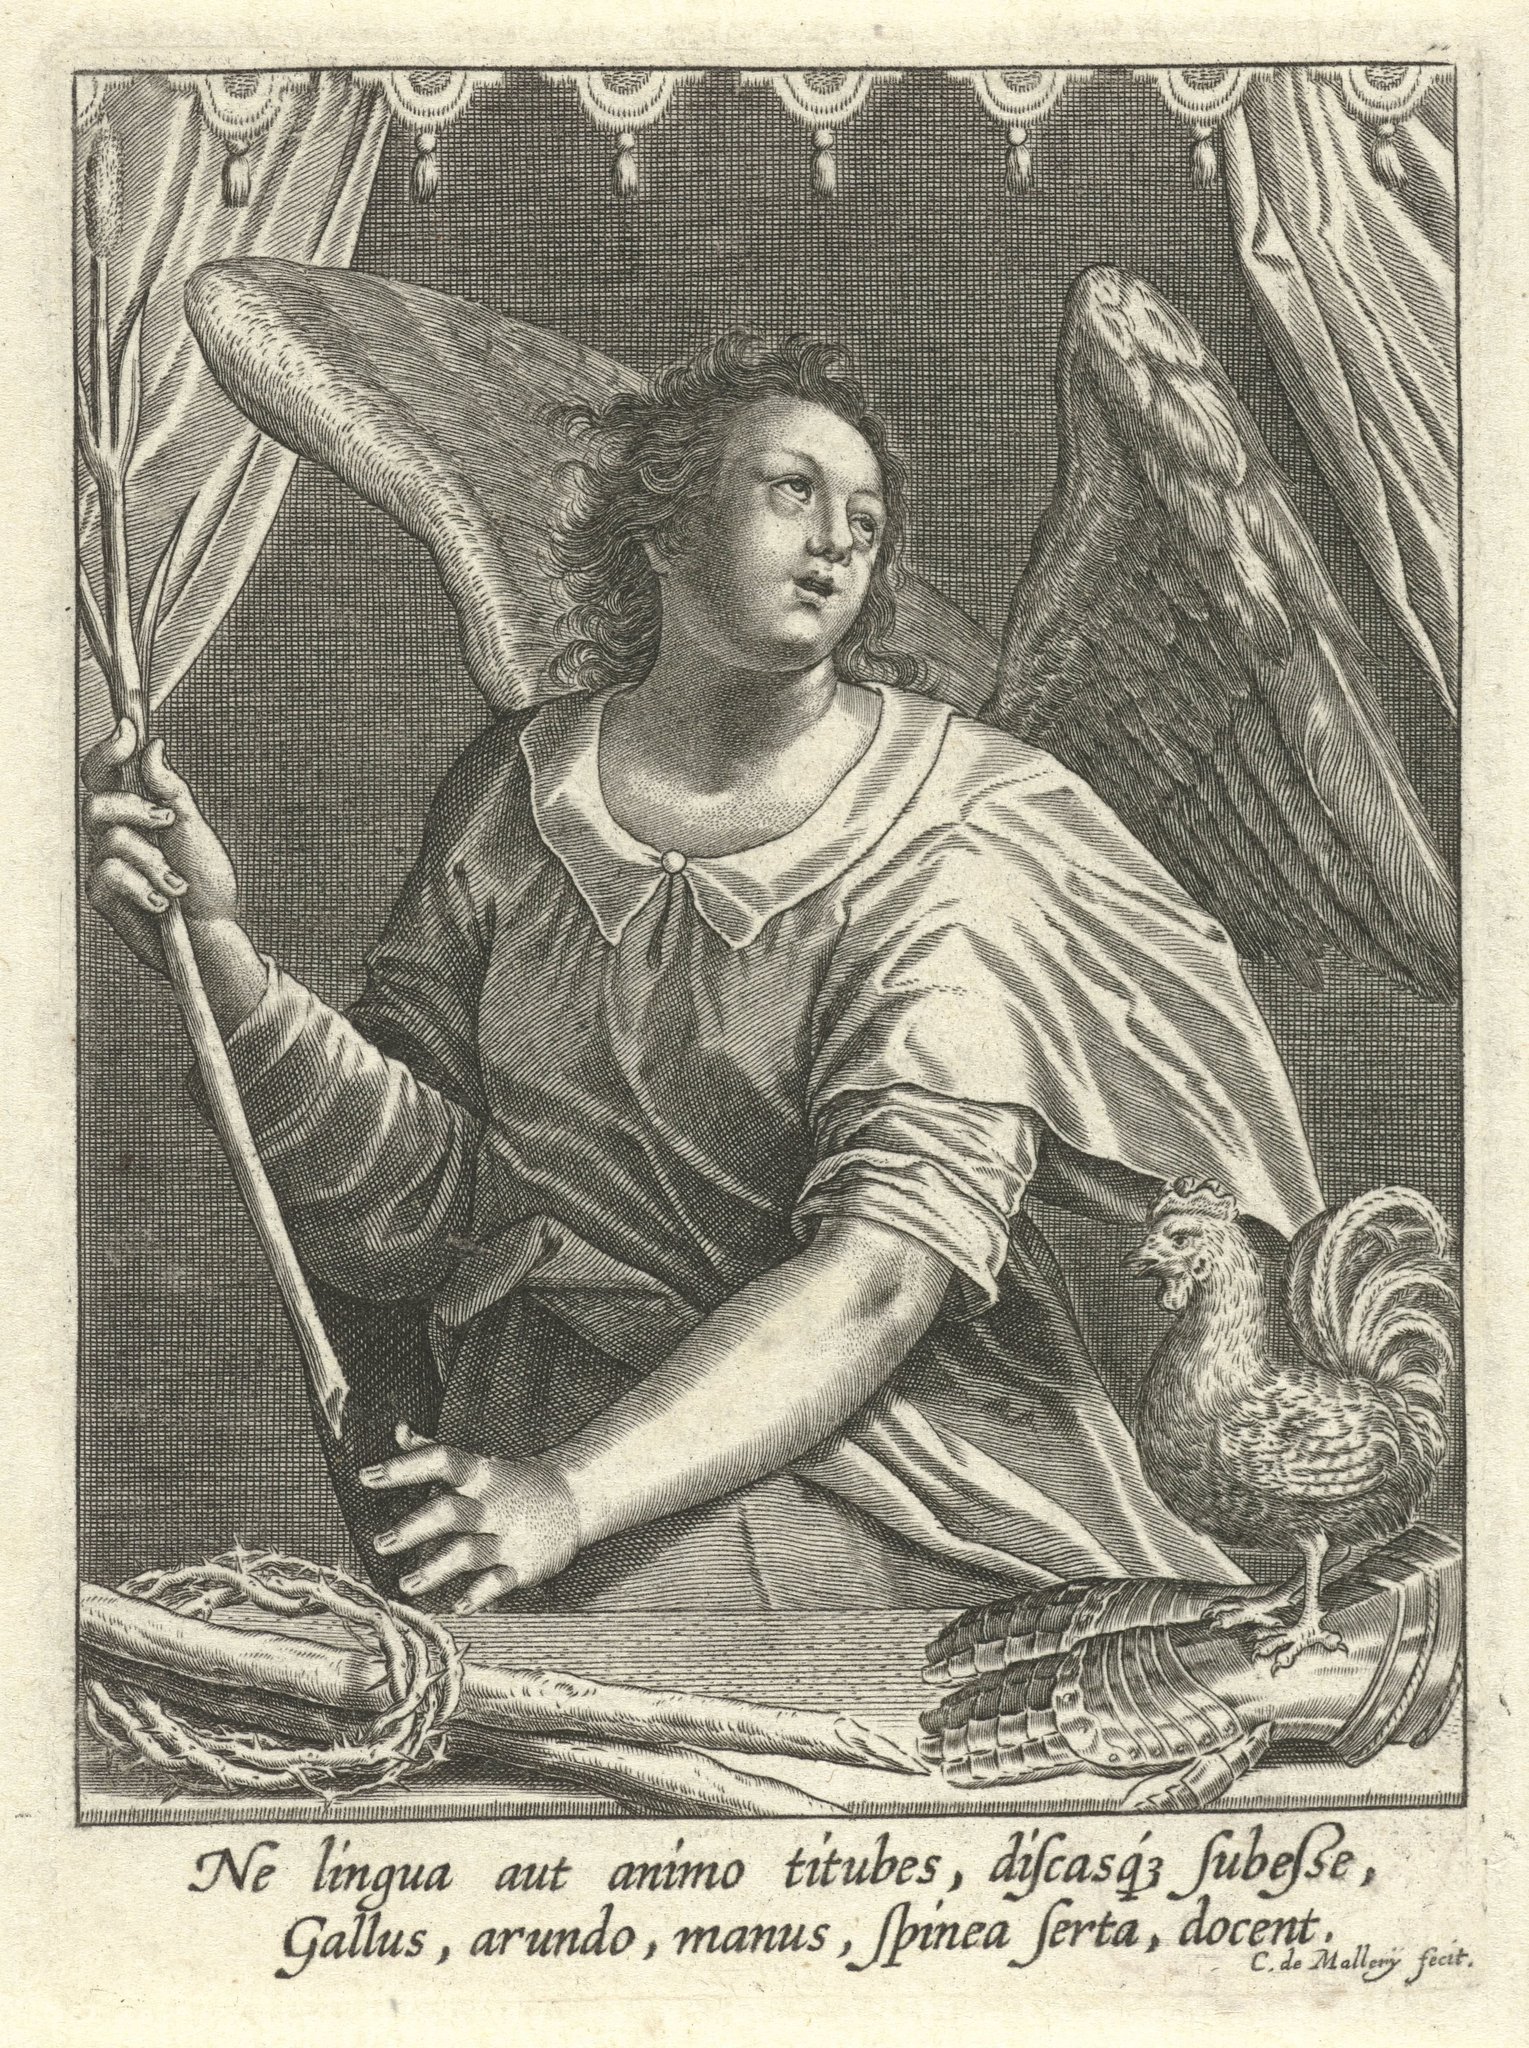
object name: print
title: Engel met haan, doornenkroon en rietstengel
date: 1581-1645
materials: paper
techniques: engraving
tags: reed ~ instruments of the passion, the crowing cock ~ denial of peter, the instruments of the passion and the five wounded limbs, crown of thorns ~ instruments of the passion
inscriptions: collector's mark: Lugt 240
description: Engel met de haan en de doornenkroon. De rietstengel verwijst naar de stok waarmee Christus aan het kruis de in wijn gedrenkte spons kreeg aangeboden. Onder de voorstelling twee regels in het Latijn. Vierde prent uit een serie van acht prenten met voorstellingen van engelen met de Passiewerktuigen.